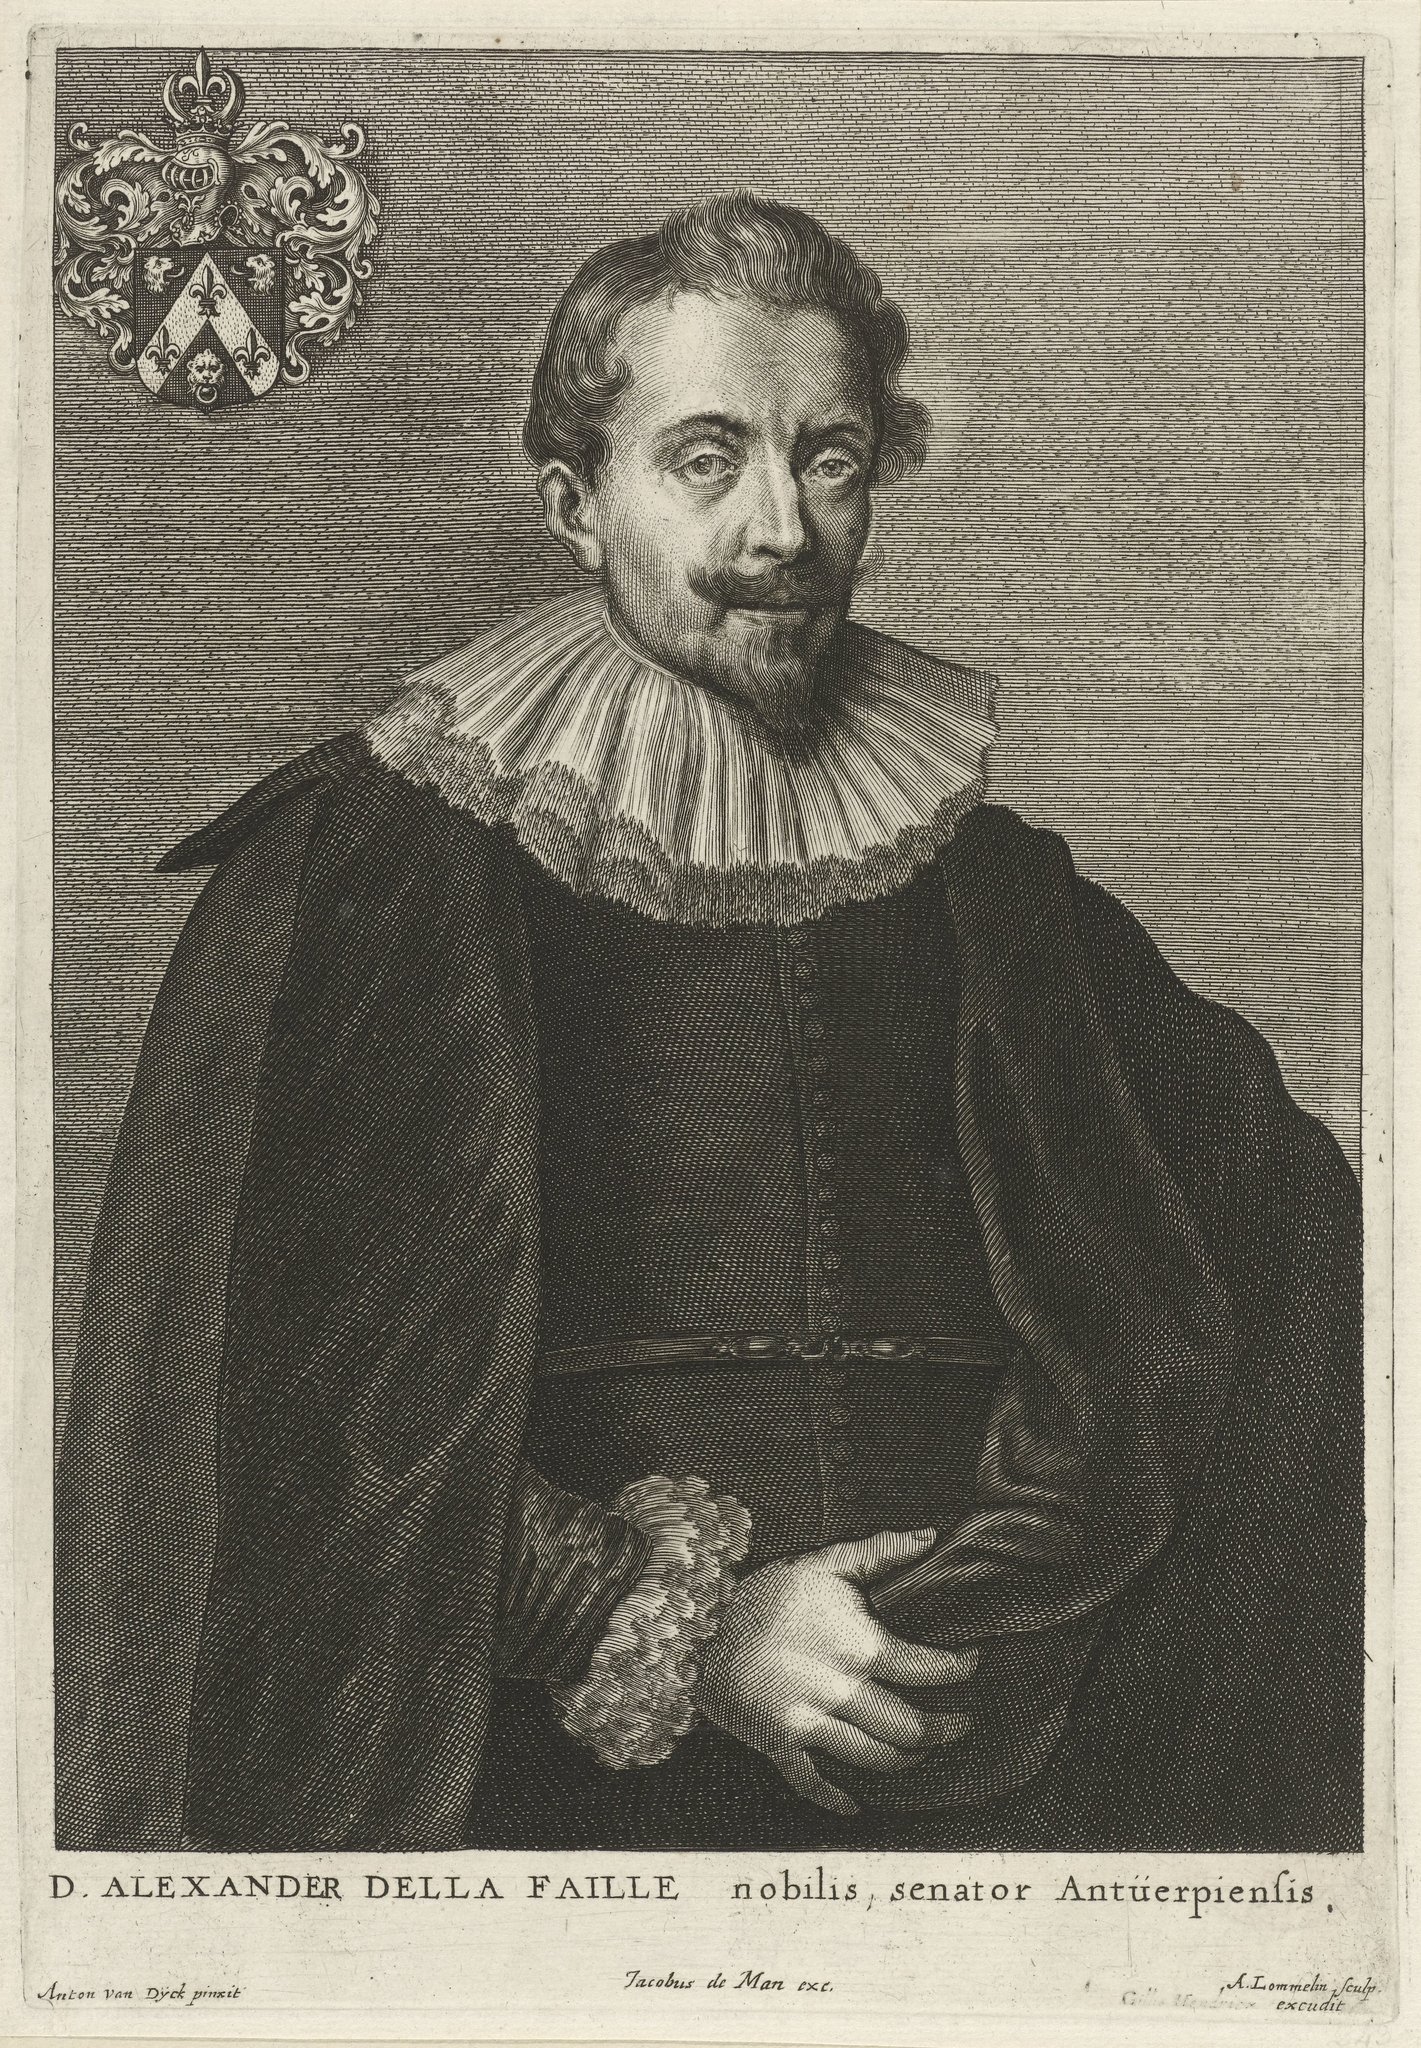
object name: print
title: Portret van Alexander de la Faille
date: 1676-1719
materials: paper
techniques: engraving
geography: antwerp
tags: raadsheer, alexander de la faille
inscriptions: collector's mark: Lugt 240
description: Portret van Alexander de la Faille, raadsheer te Antwerpen, met wapenschild in linker bovenhoek.